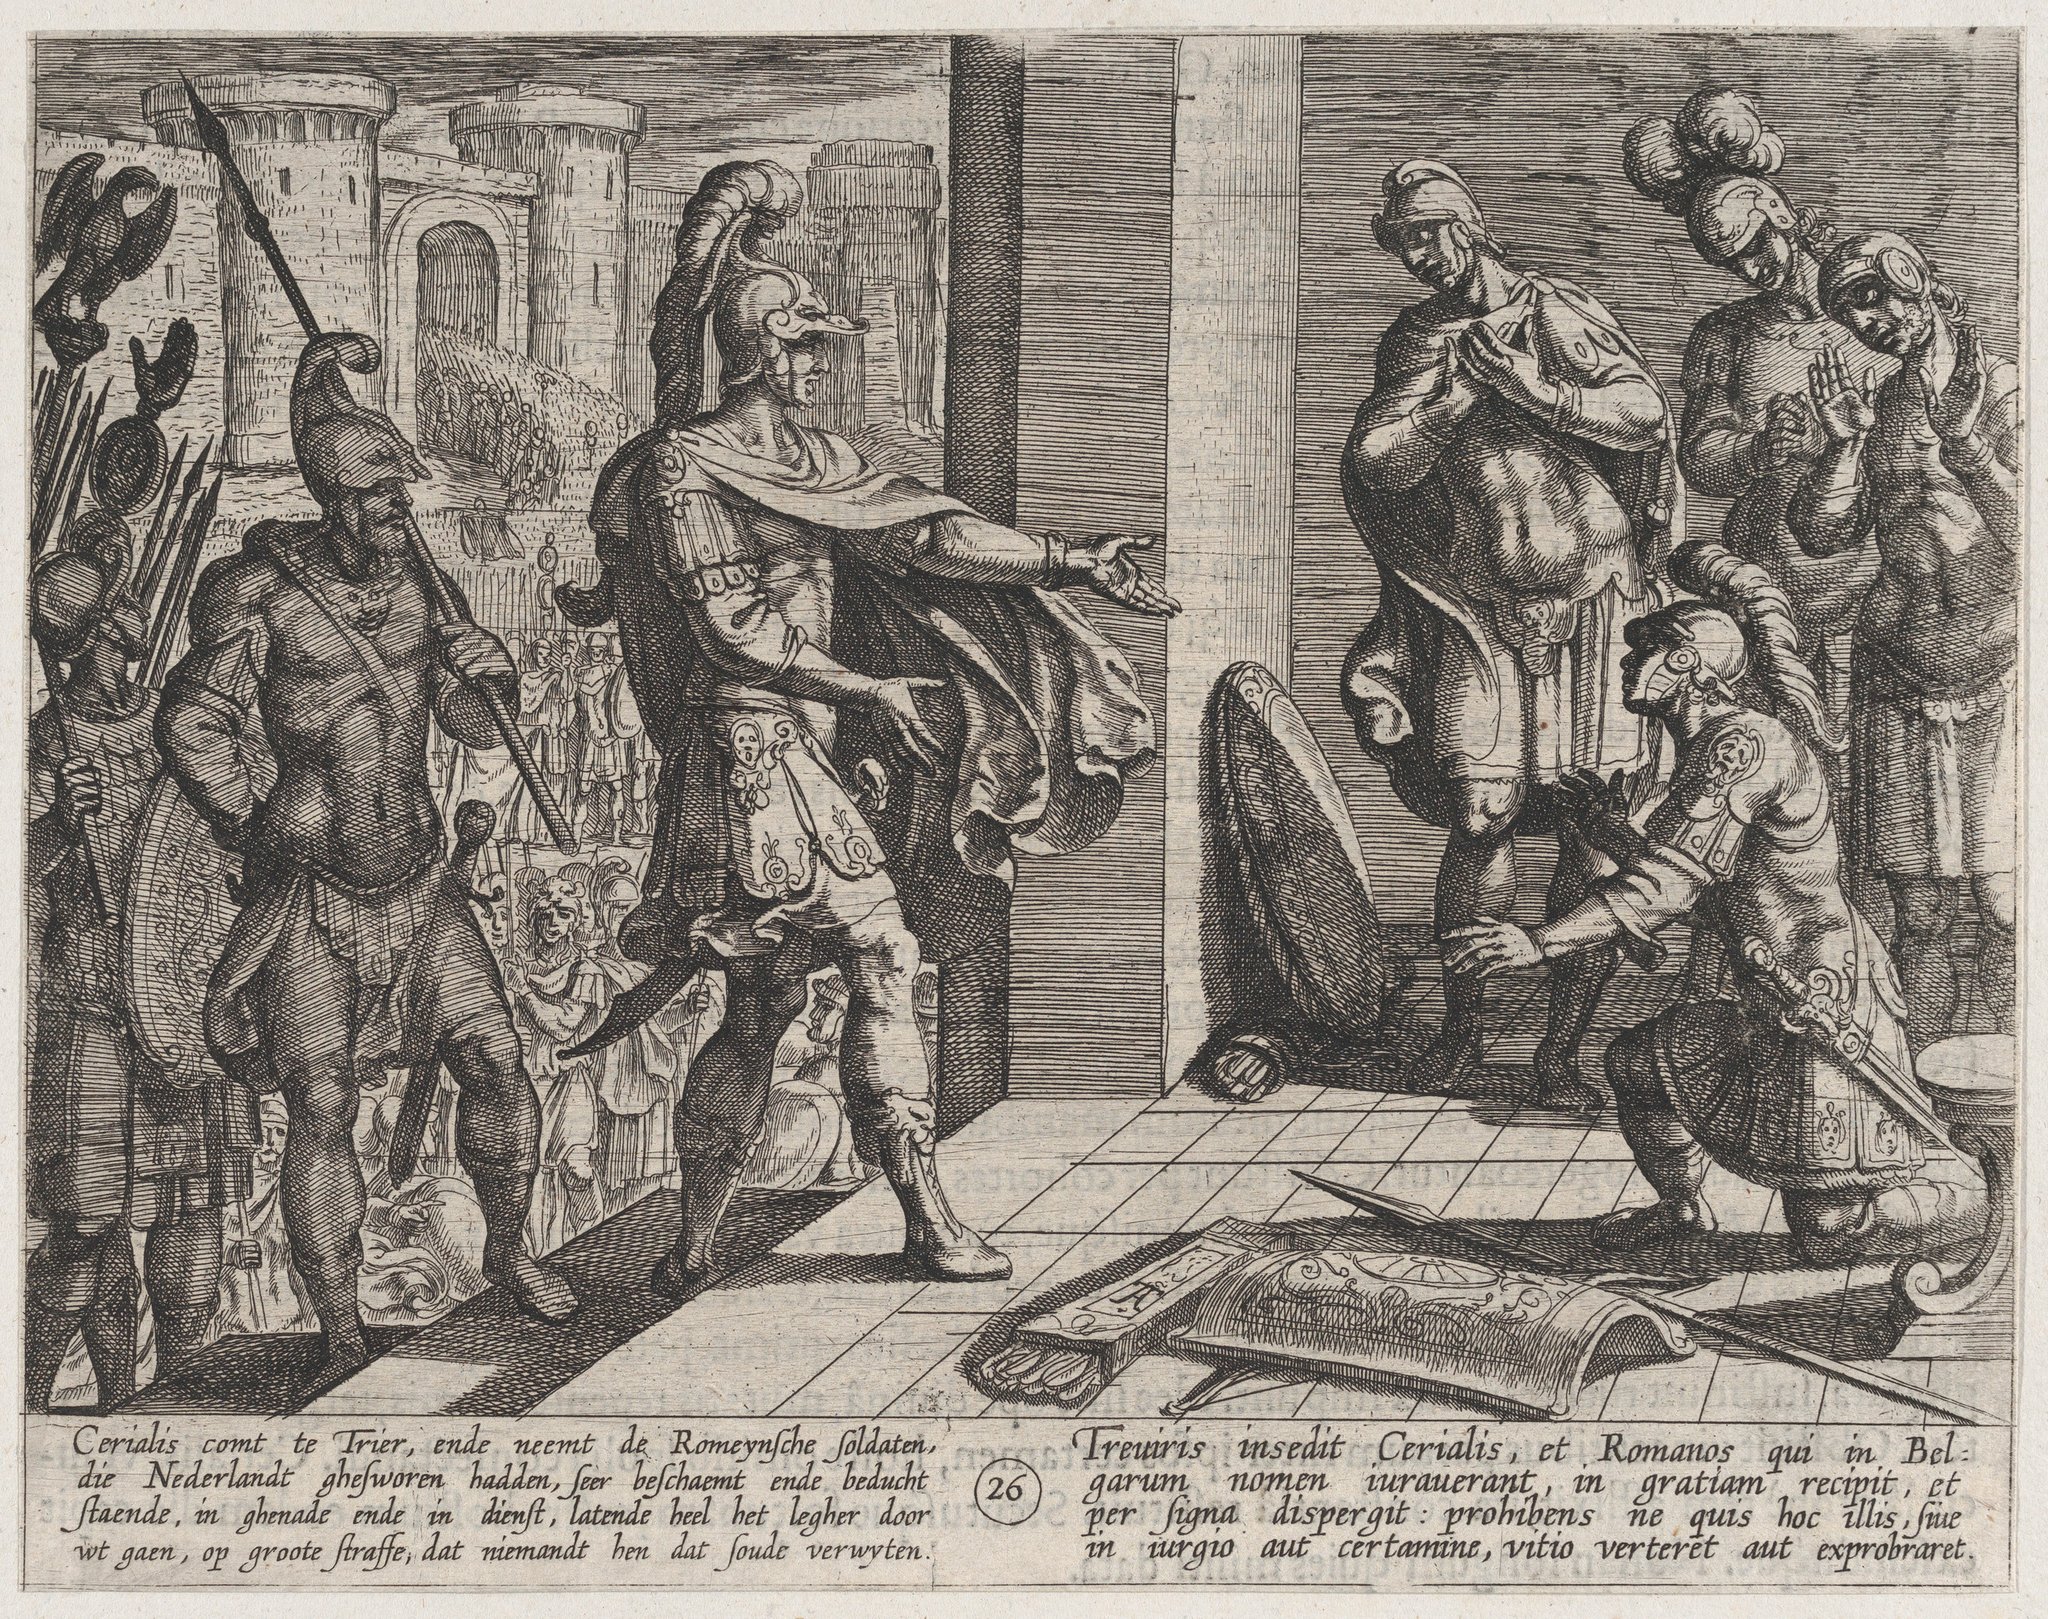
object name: print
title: Plate 26: Cerialis Pardons and Relieves Roman Soldiers who had Helped Civilis, from The War of the Romans Against the Batavians (Romanorvm et Batavorvm societas)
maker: antonio tempesta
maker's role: artist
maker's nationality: italian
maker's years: 1555-1630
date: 1611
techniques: etching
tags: human figures,soldiers,bow and arrow,spears